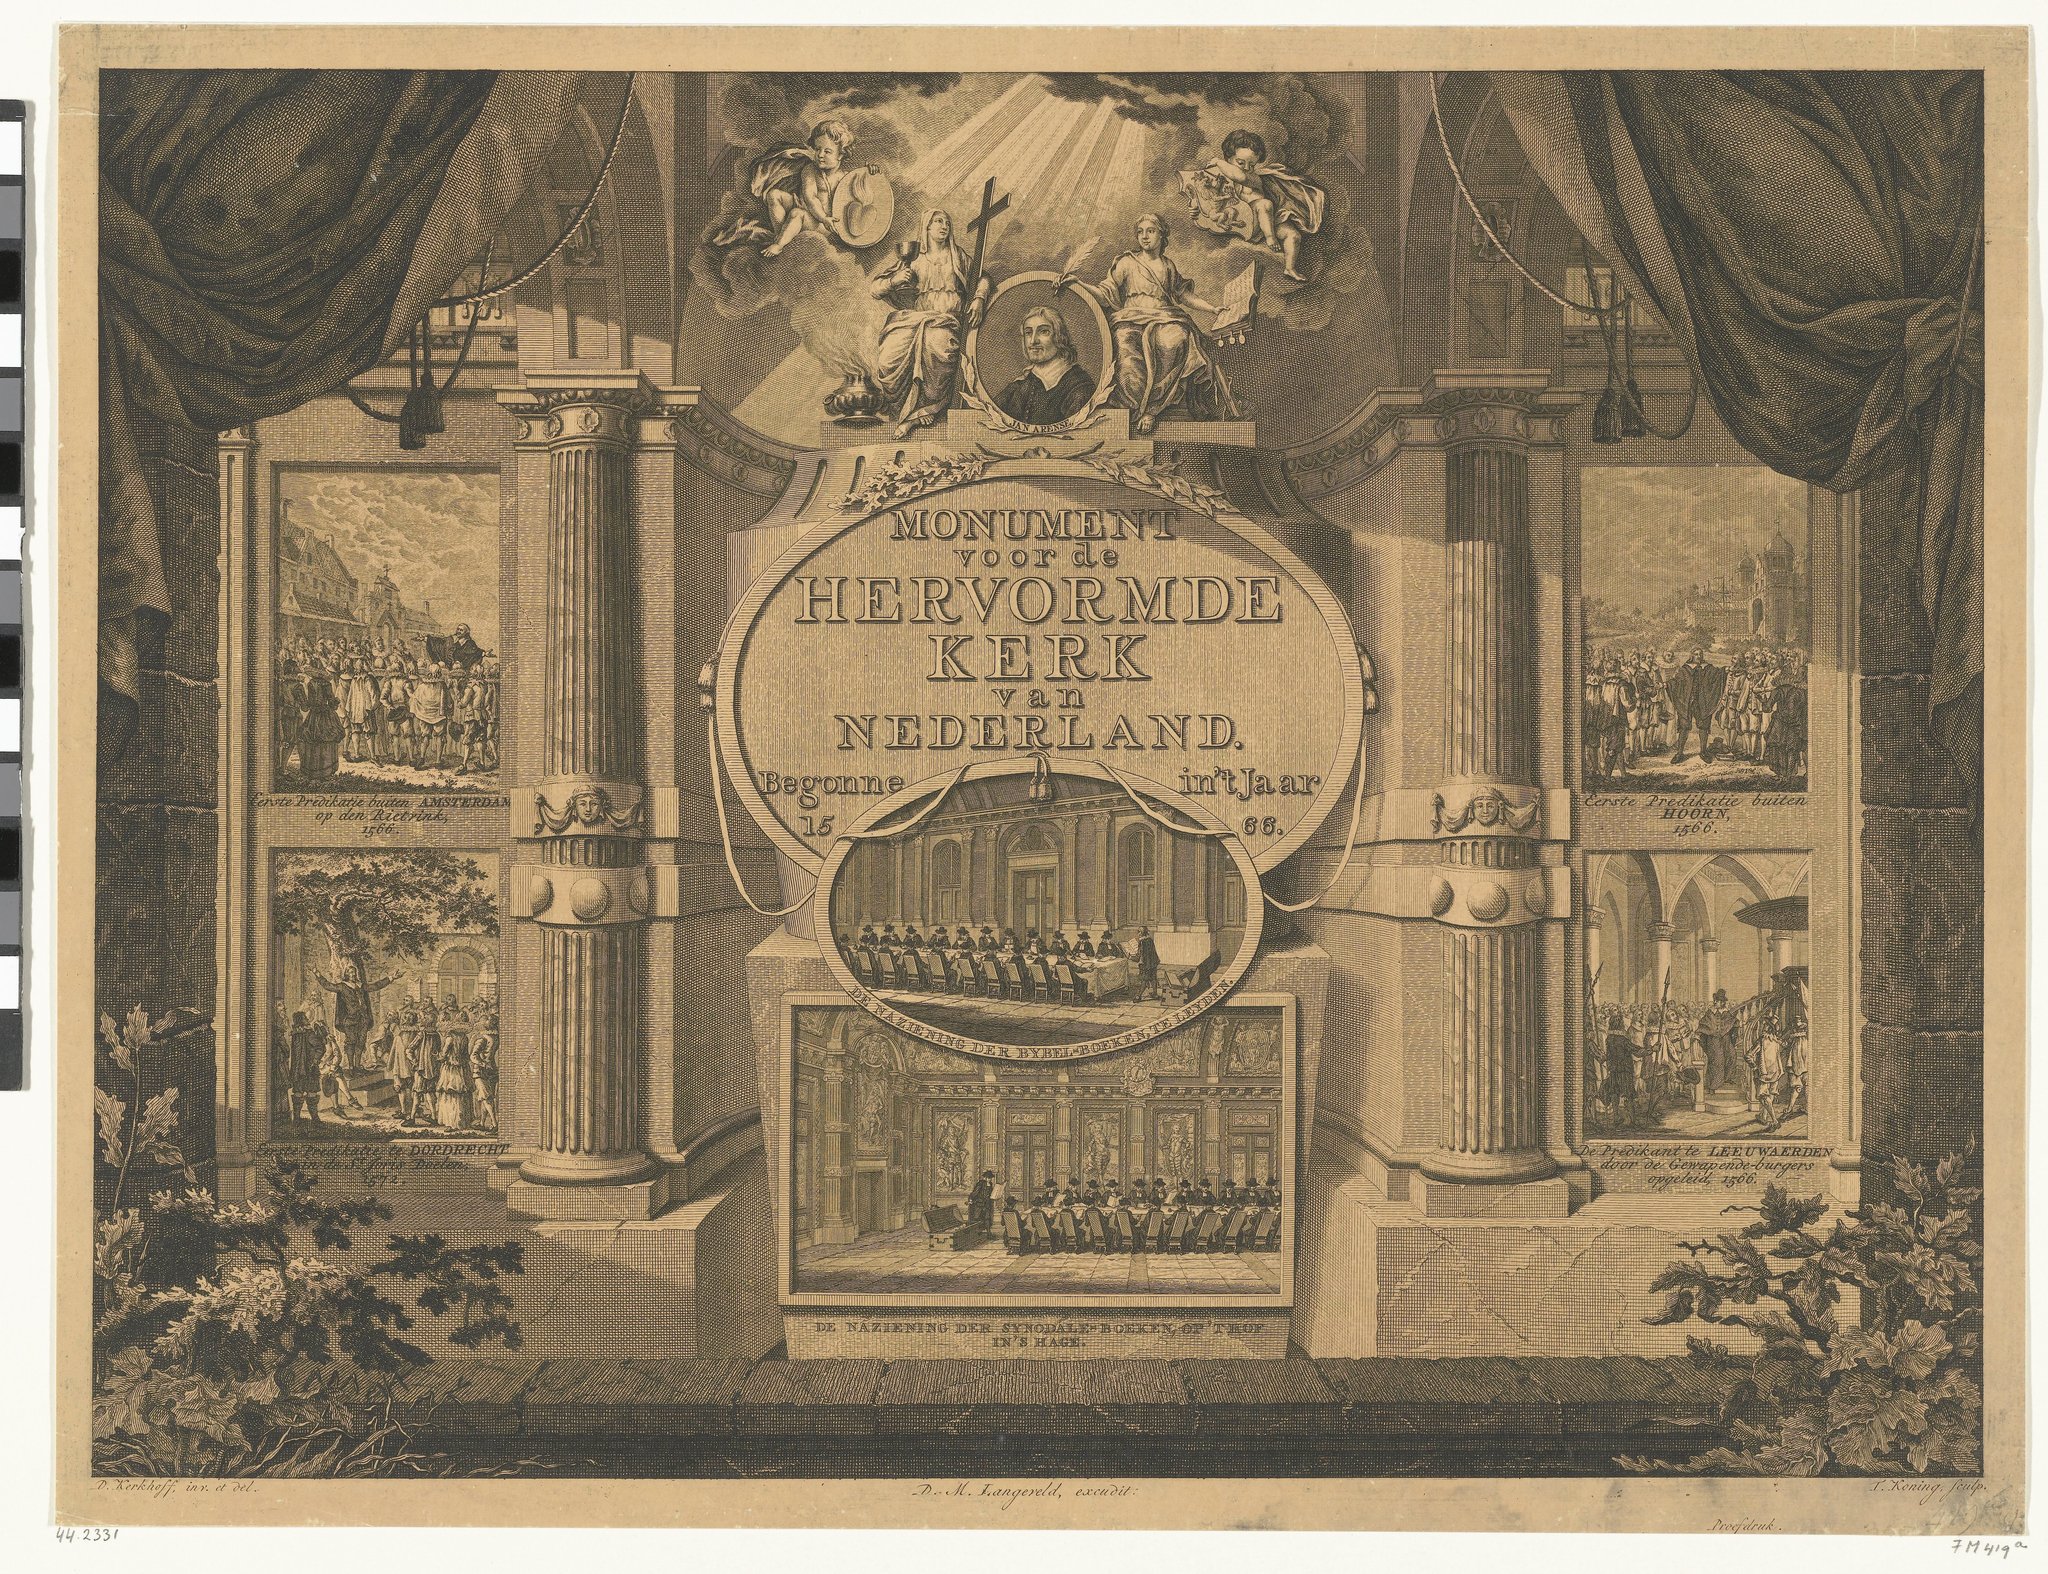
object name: print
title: Monument voor de Hervormde Kerk van Nederland, vanaf 1566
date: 1780-1796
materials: paper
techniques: etching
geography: netherlands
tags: leiden, the hague, dordrecht, amsterdam, hoorn (north holland)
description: Monument voor de Hervormde Kerk van Nederland, vanaf 1566. Boven een klein portret van de eerste lutherse predikant Jan Arentsz, links en rechts scènes van de eerste calvinistische predikingen in de jaren 1566 en 1572 te Amsterdam, Hoorn, Leeuwarden en Dordrecht. In het midden het nazien van de bijbelvertaling te Leiden en Den Haag. Allegorie op de Hervorming.